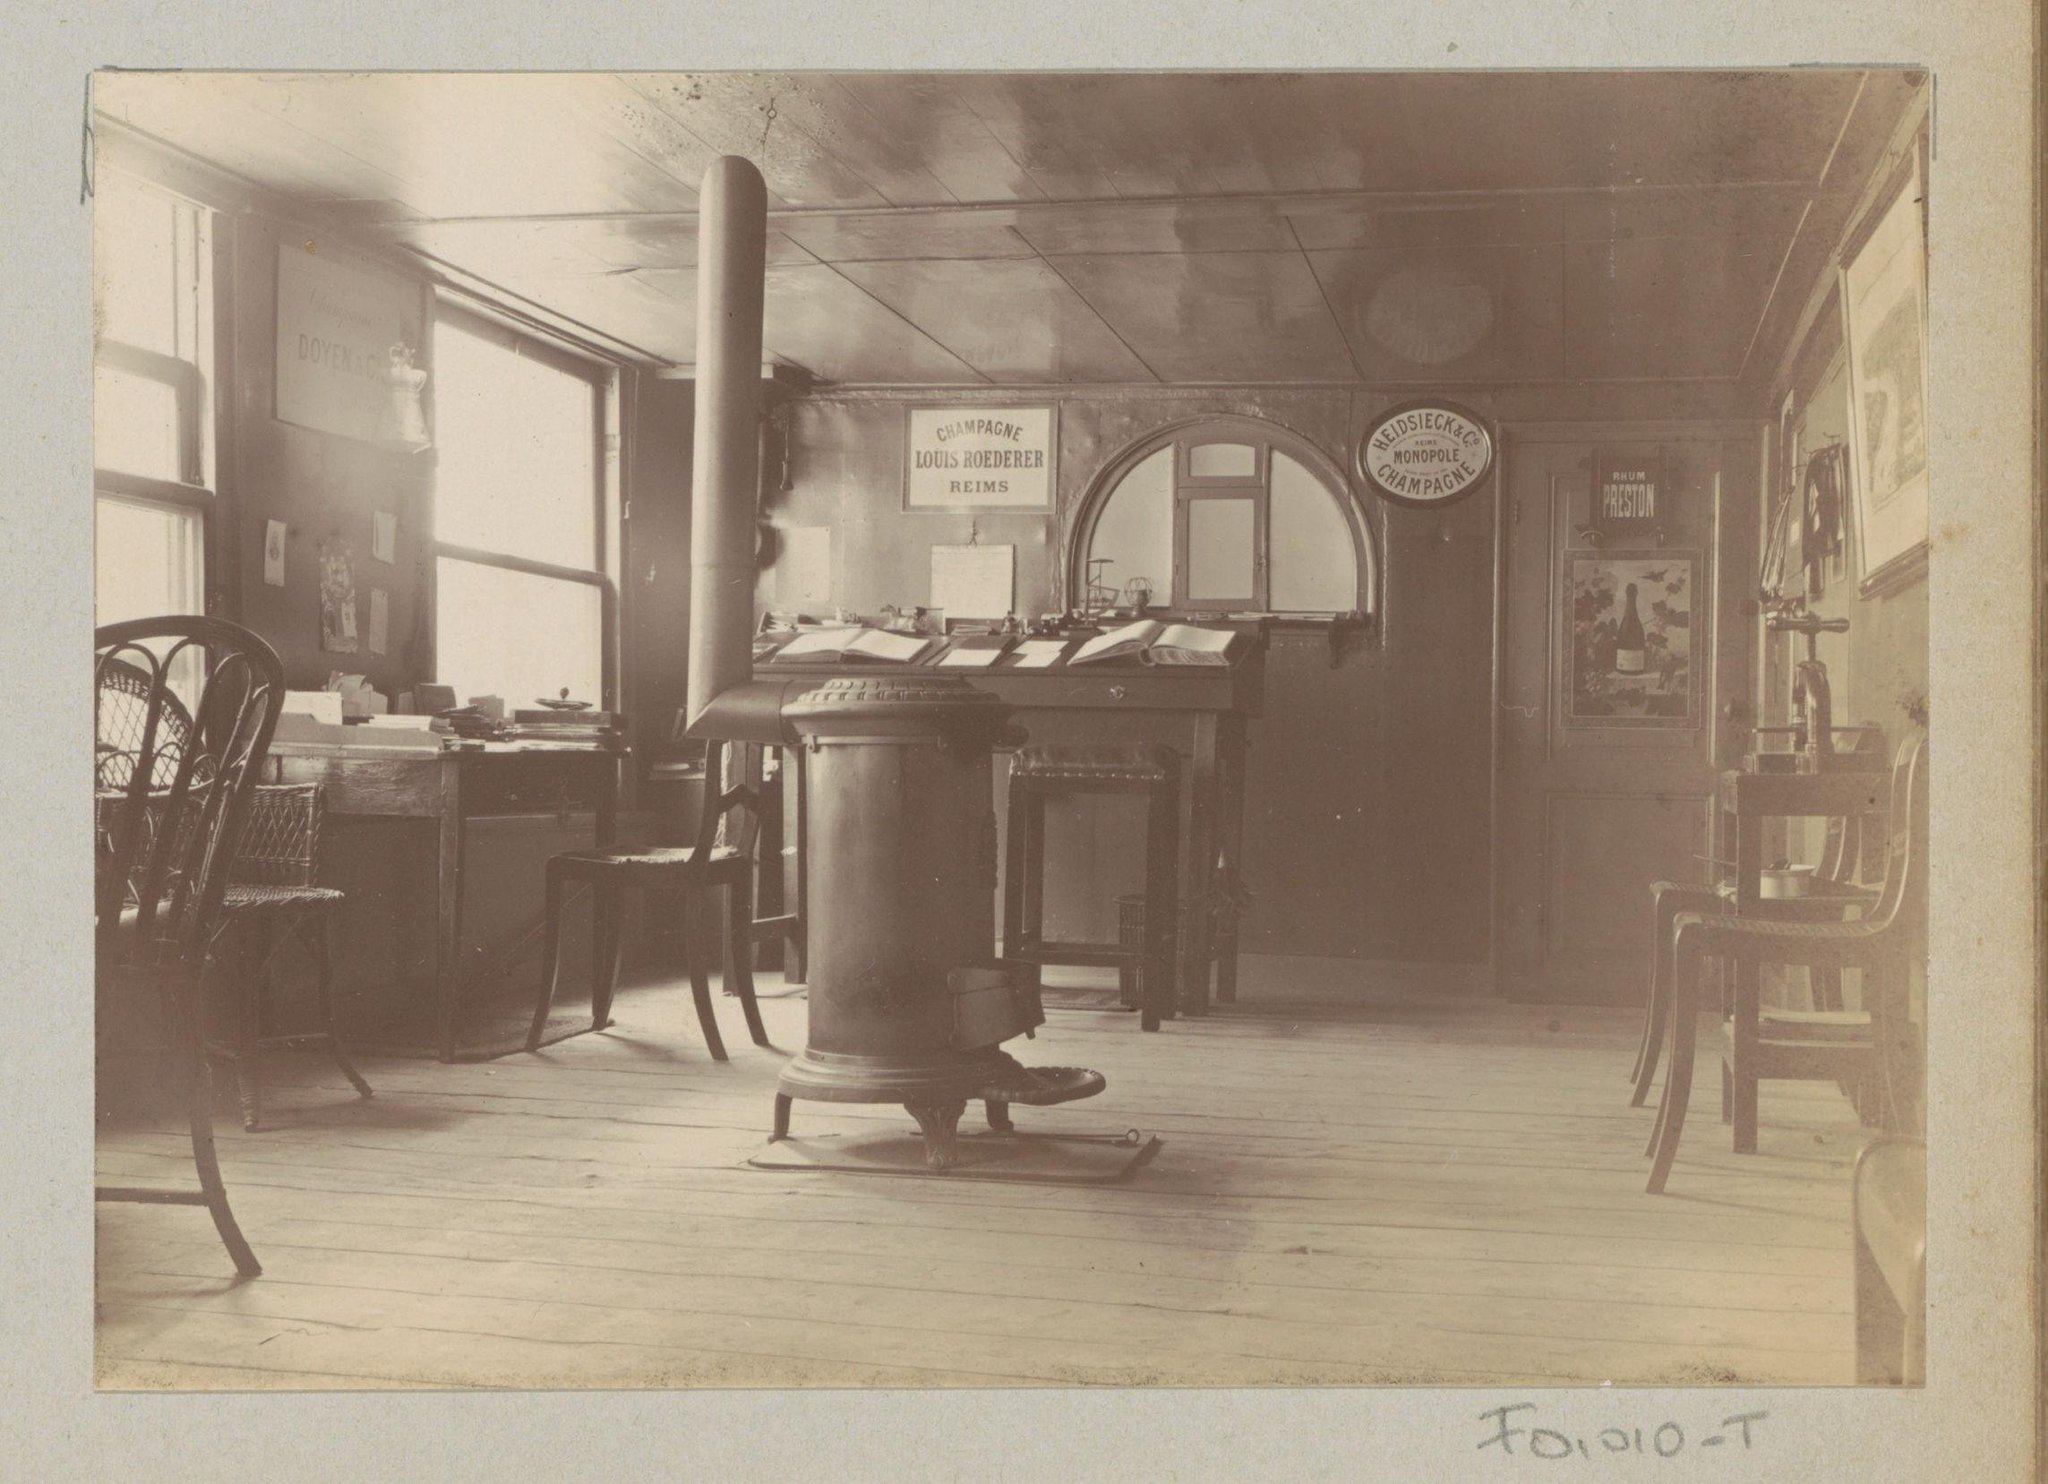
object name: photograph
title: Interieur van een kantoor behorend bij een brouwerij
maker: Anonymous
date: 1900-1910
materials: photographic support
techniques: daylight paper print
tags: office (~ administration), heating stove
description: Onderdeel van Familiealbum met onder meer foto's van Wijnhandel Kraaij & Co. Bordeaux-Amsterdam.